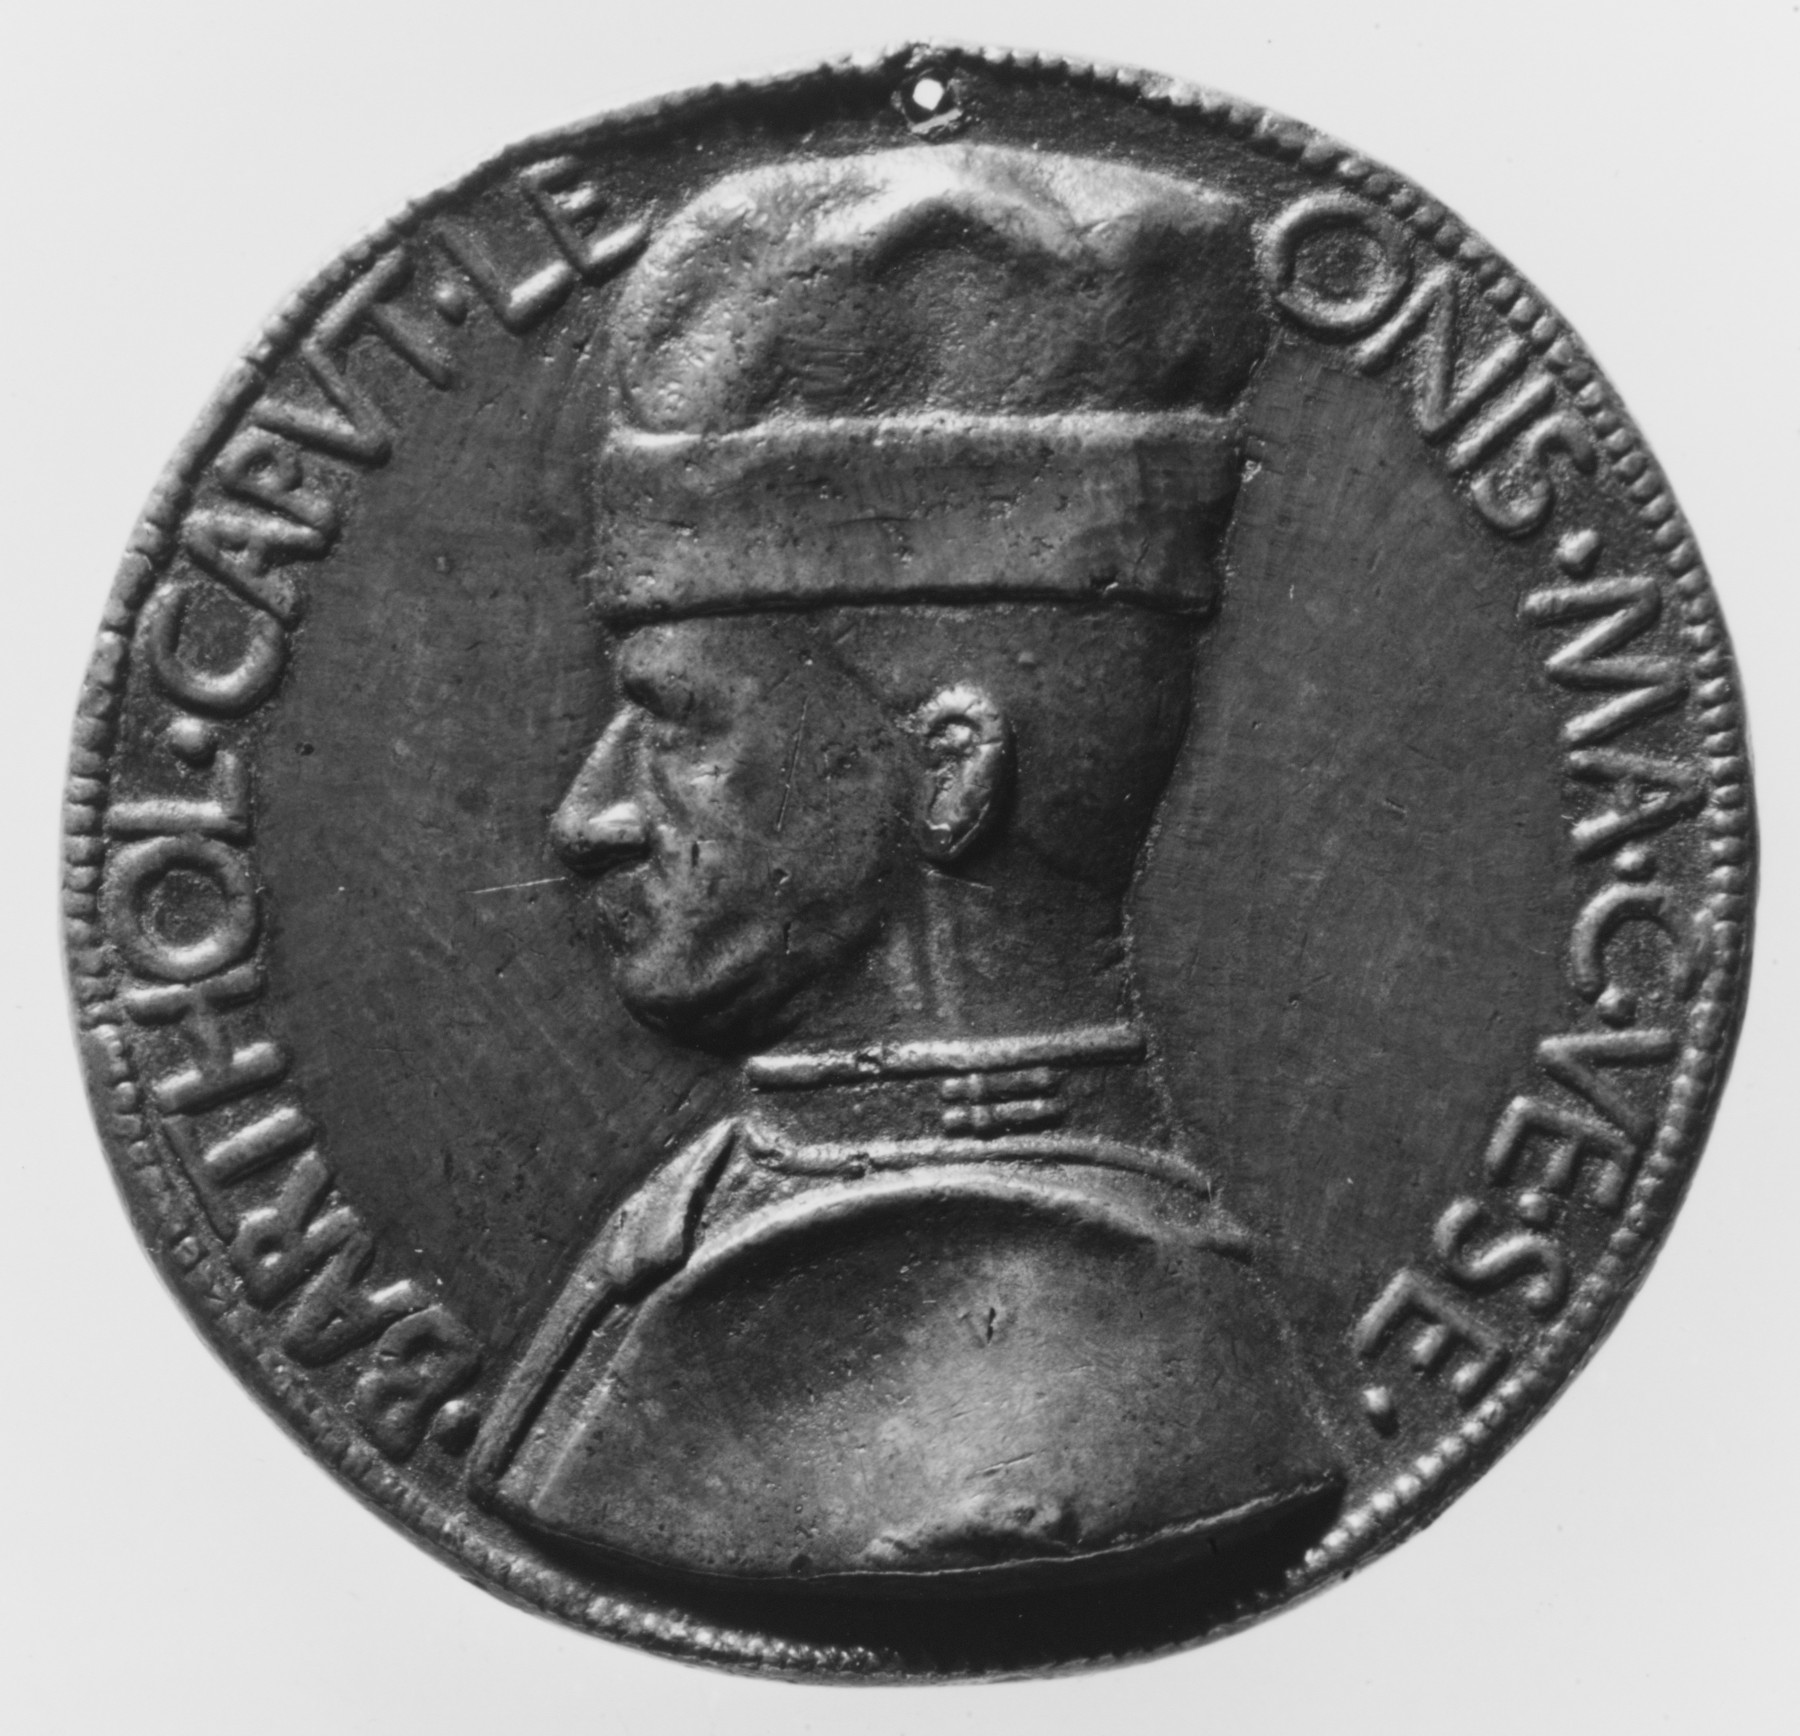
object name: medal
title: Bartolommeo Colleone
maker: marco guidizani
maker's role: artist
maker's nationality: italian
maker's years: 1454-1462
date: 1460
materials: bronze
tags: men,profiles